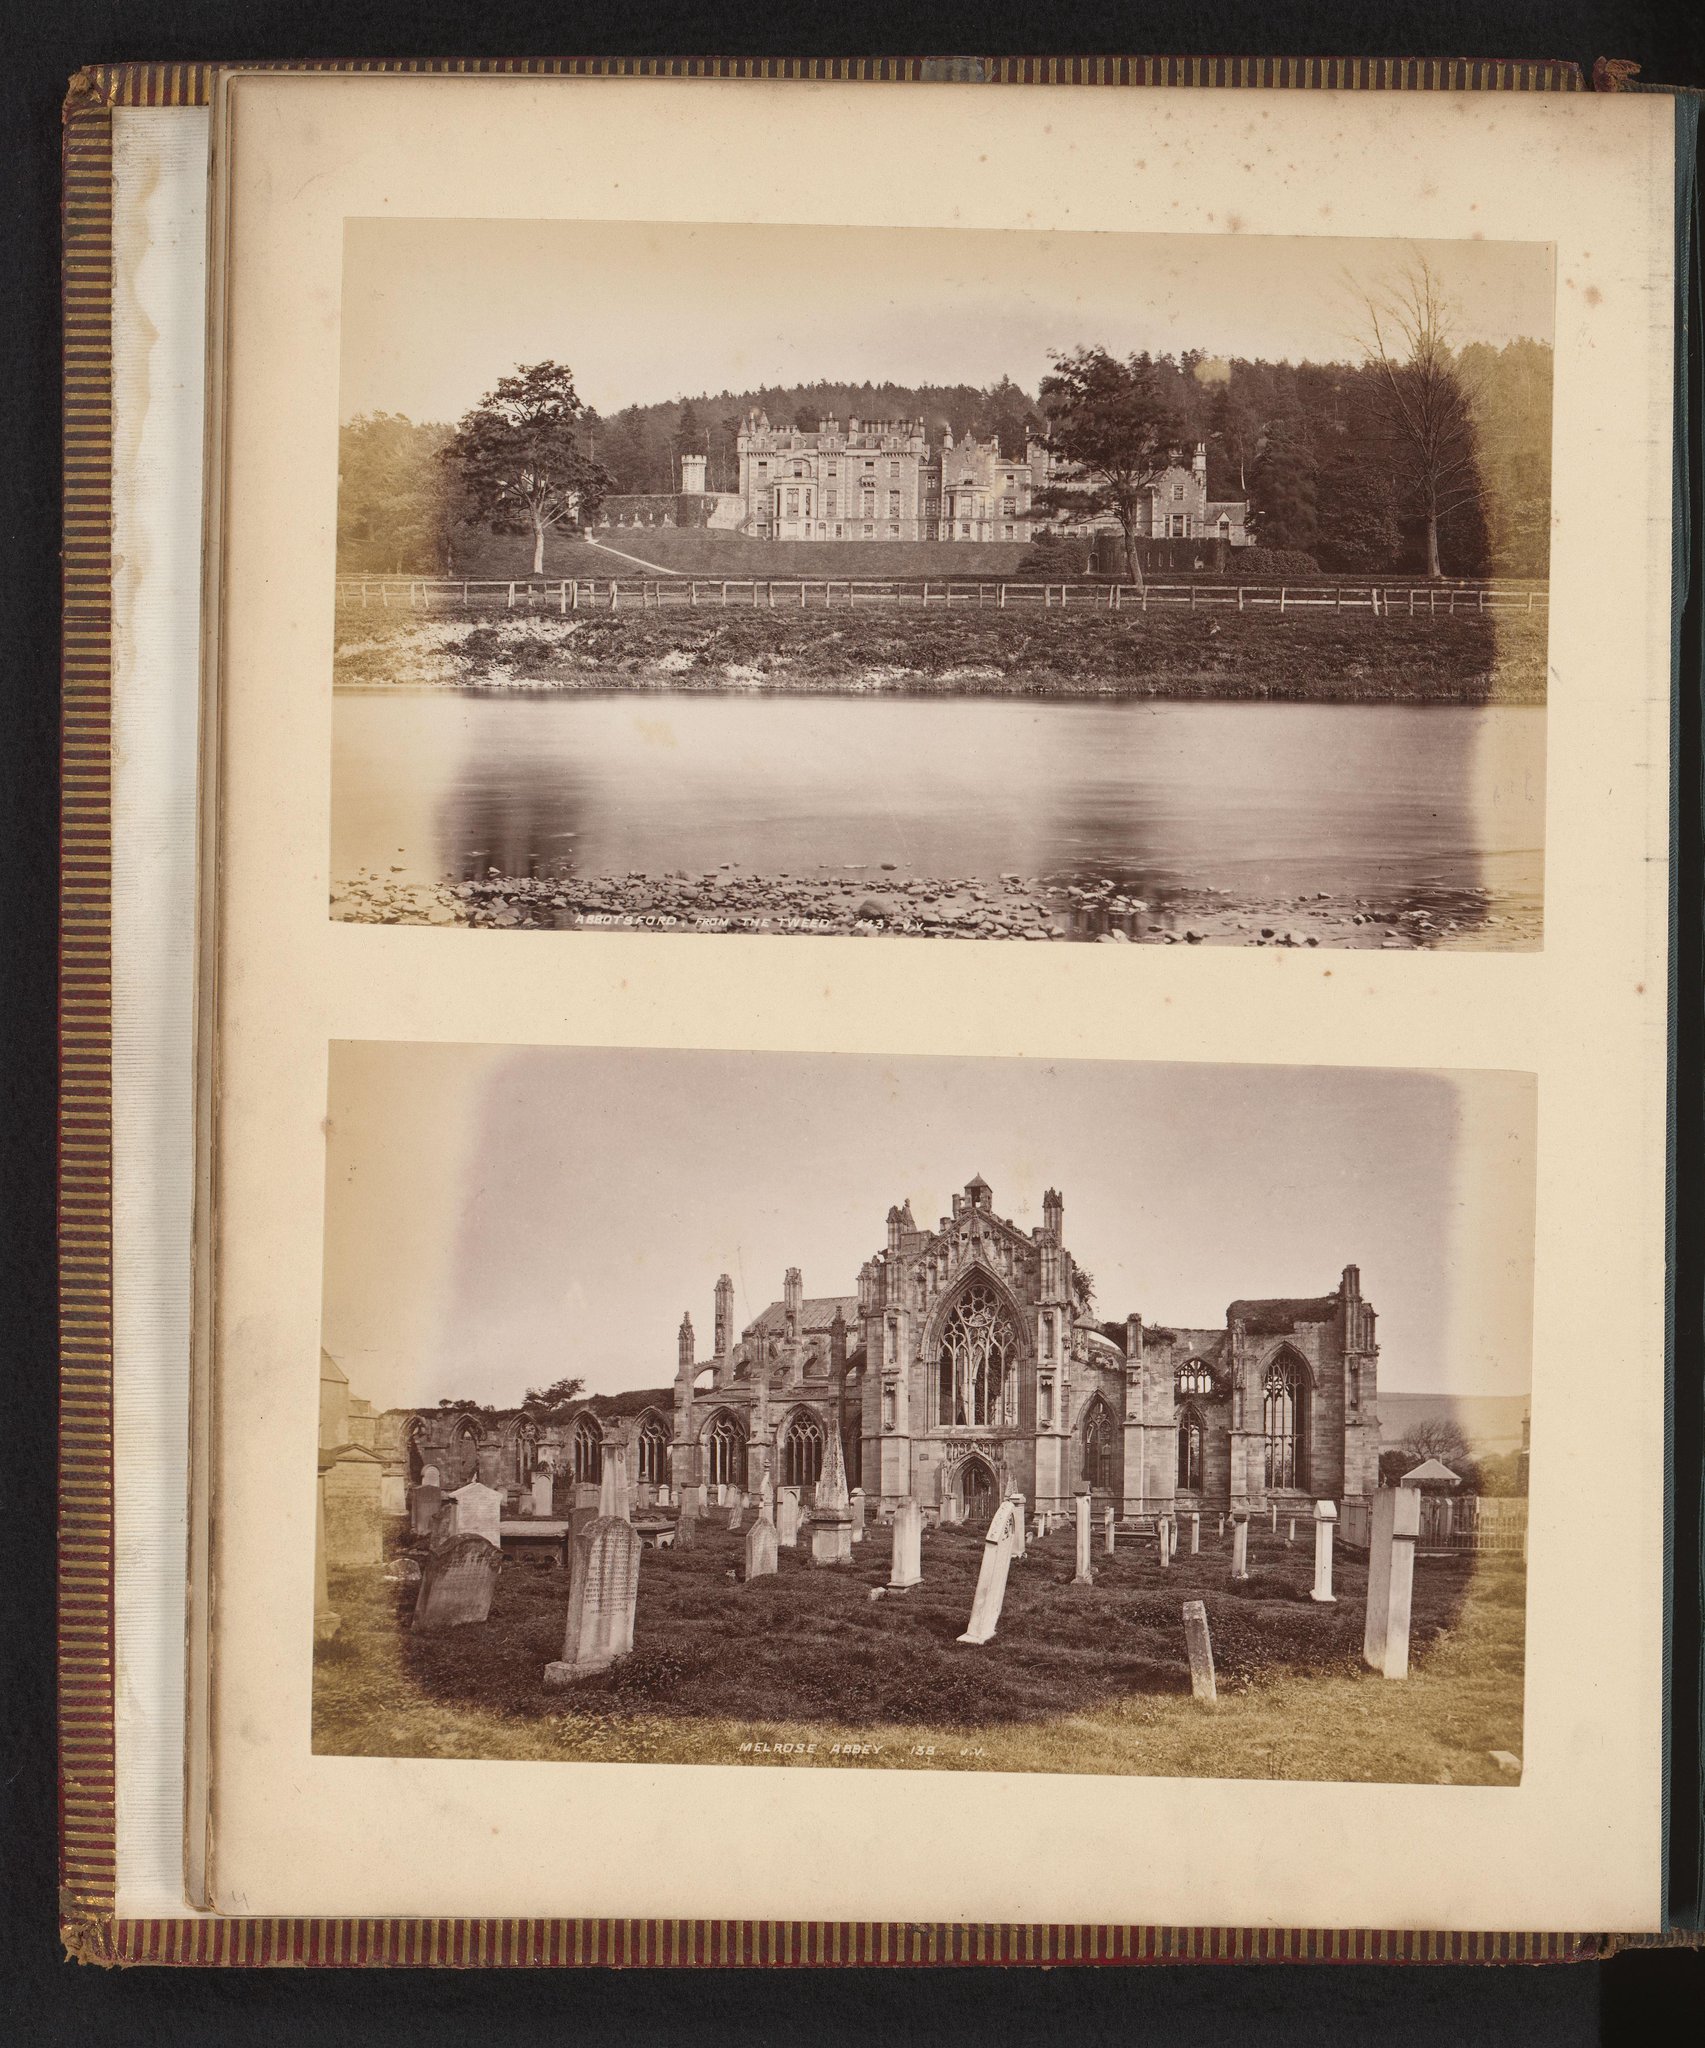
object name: album leaf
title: Melrose Abbey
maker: Anonymous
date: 1875-1885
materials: photographic support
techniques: albumen print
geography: melrose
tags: river, abbey, monastery, convent ~ roman catholic church, country-house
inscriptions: number: ‘443, J.V.’, number: ‘138, J.V.’